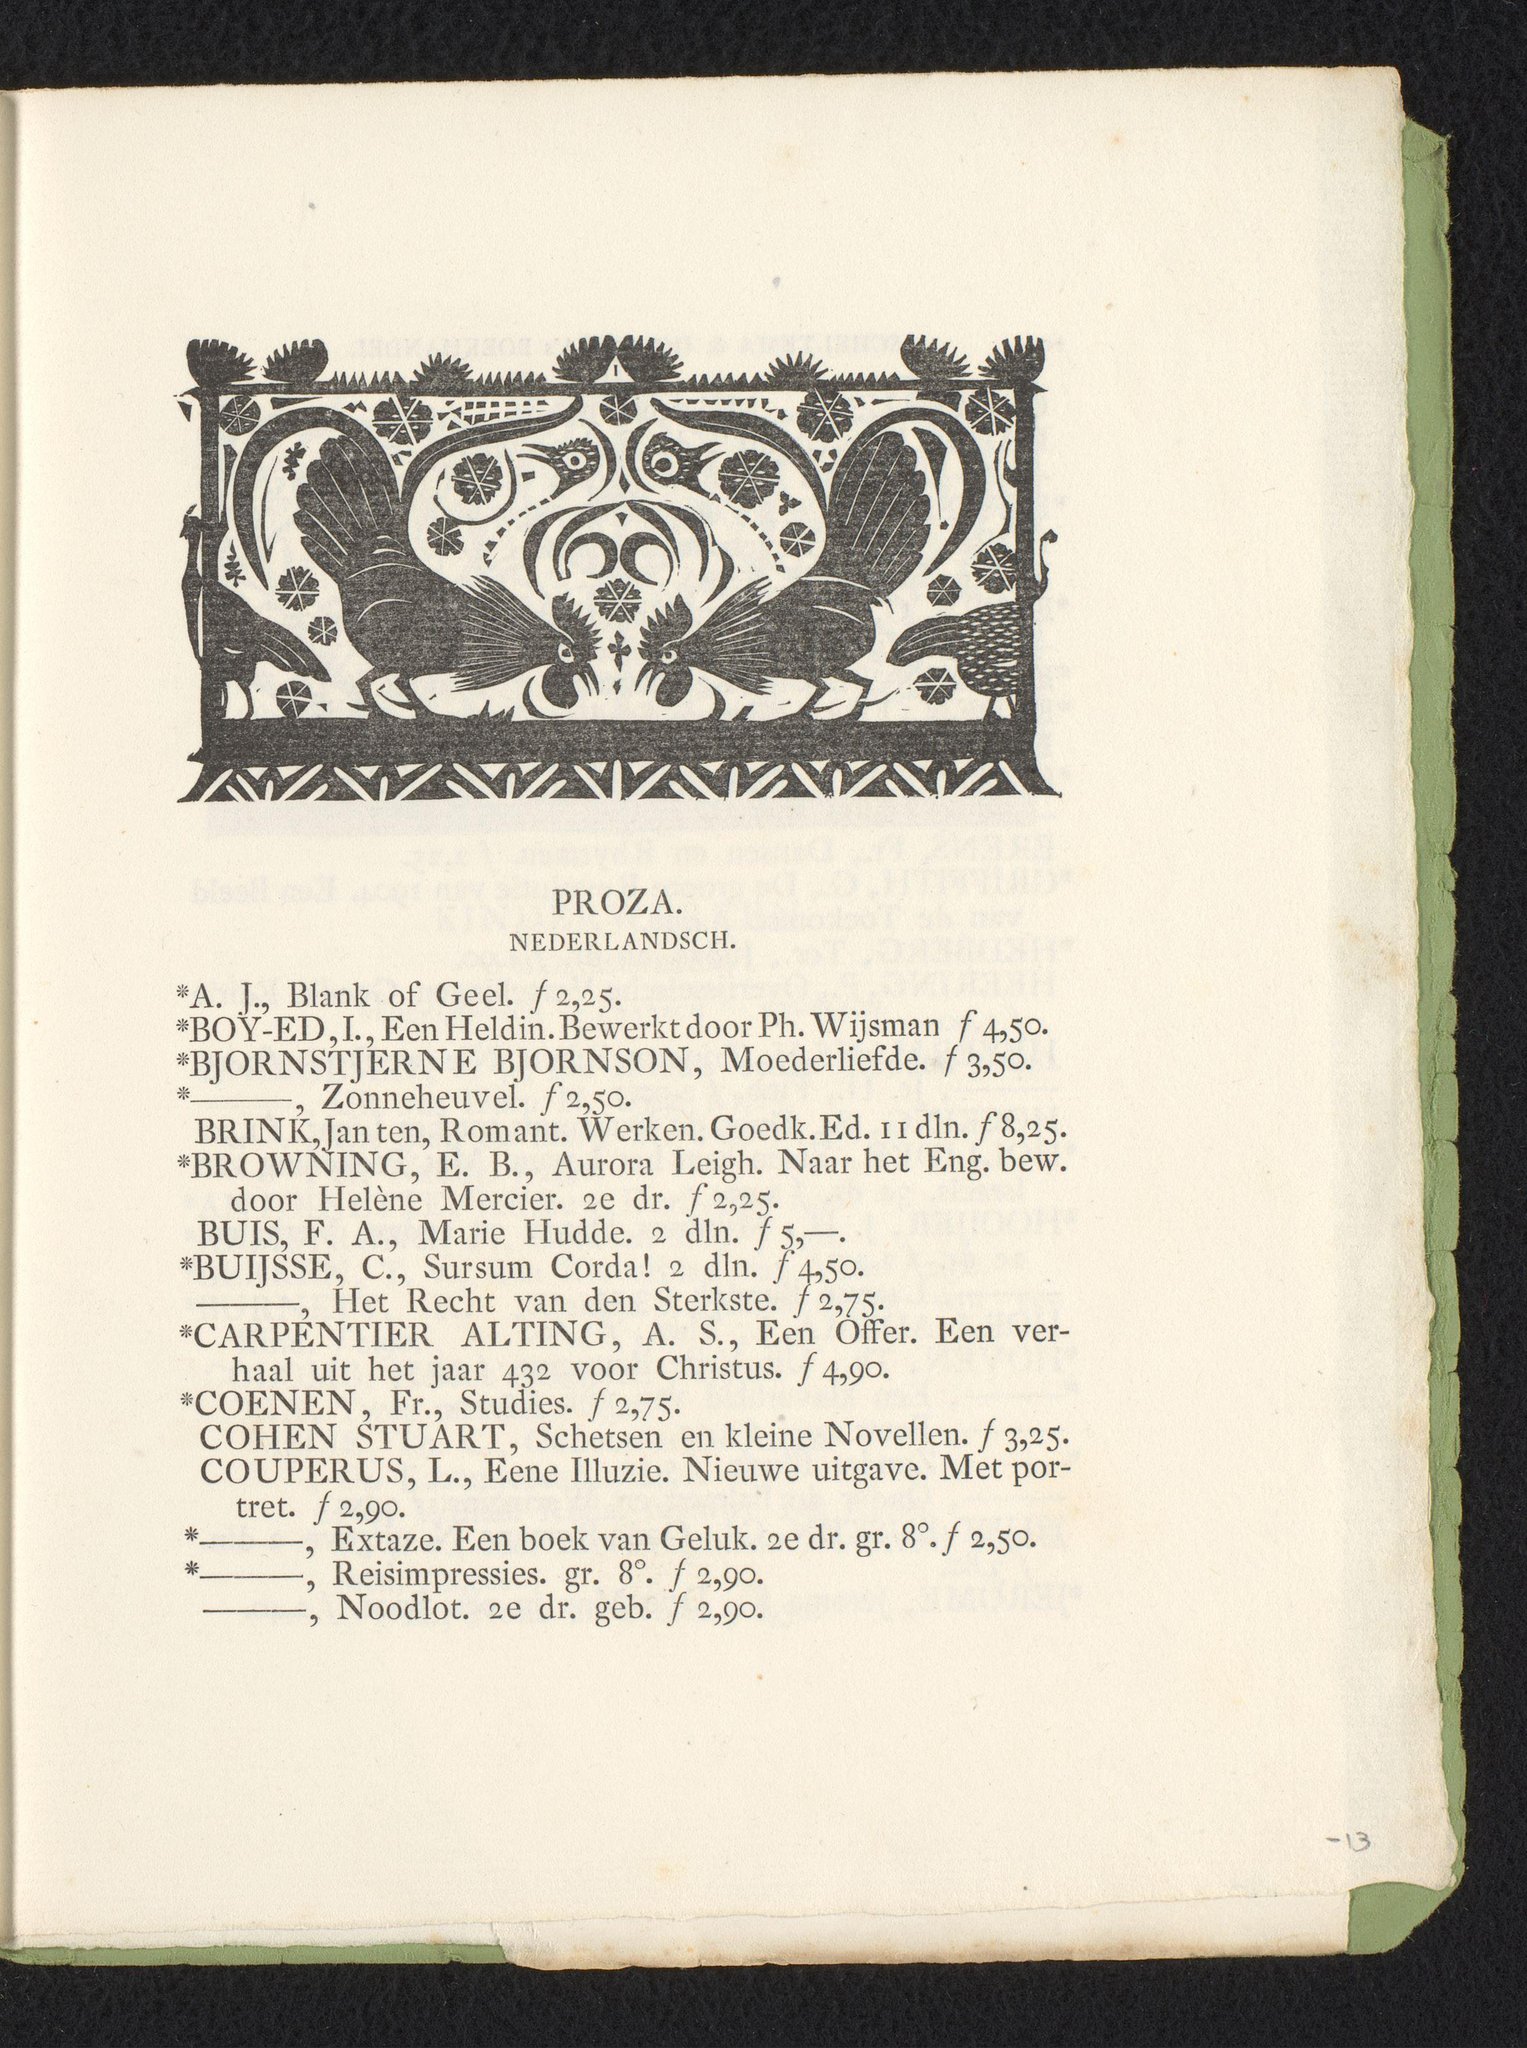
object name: print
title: Titelhoofd met hanen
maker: gerrit willem dijsselhof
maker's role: designer, draughtsman, print maker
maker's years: 1866-1924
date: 1893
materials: paper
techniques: letterpress printing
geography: amsterdam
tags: fowl (cock, hen, chicken, etc.)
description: Prent uit: Catalogus van handboeken, pracht- en plaatwerken, dicht- en prozabundels en kinderliteratuur (...). Amsterdam: Scheltema & Holkema's Boekhandel, 1894, p. 19. Deze prent werd origineel ontworpen ter illustratie van: Crane, Walter. Kunst en samenleving. [Vertaald uit het Engels door] Jan Veth. Amsterdam: Scheltema & Holkema's Boekhandel, 1894 [1893], p. 61.